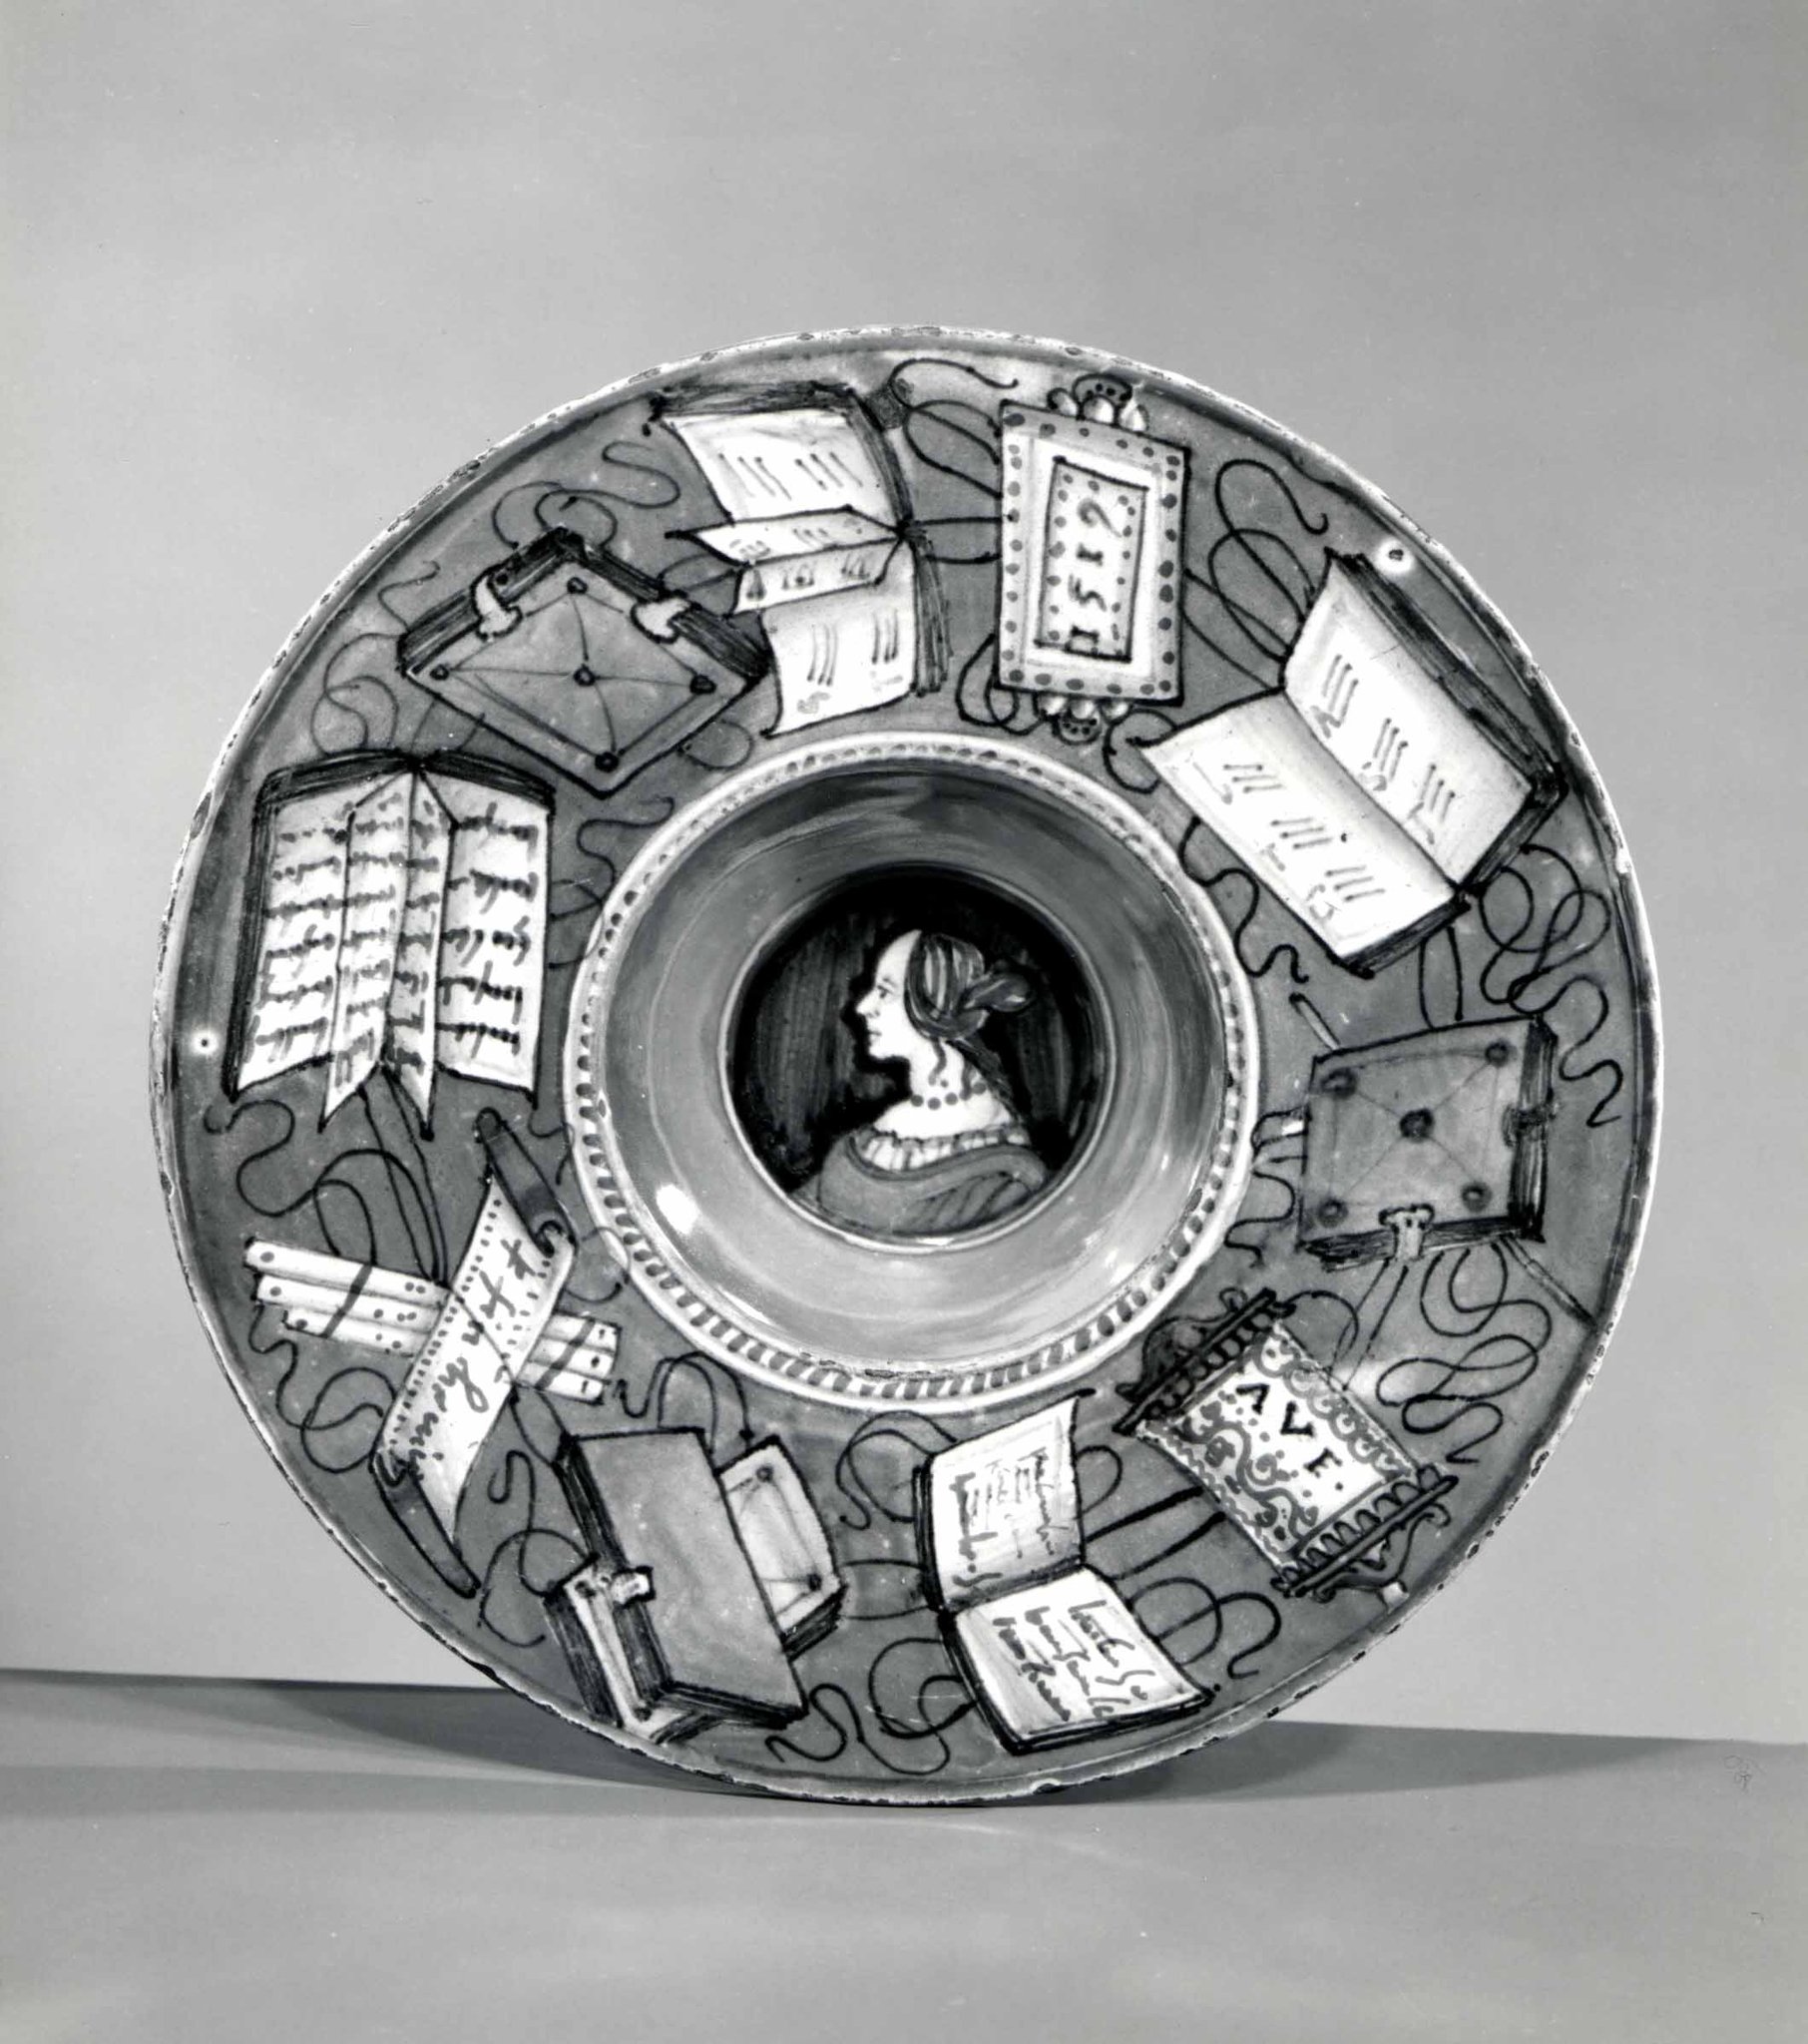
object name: plate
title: Plate (tondino)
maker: maestro giorgio andreoli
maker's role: artist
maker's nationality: italian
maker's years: 1500-1550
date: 1519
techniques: maiolica, glazing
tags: books,women